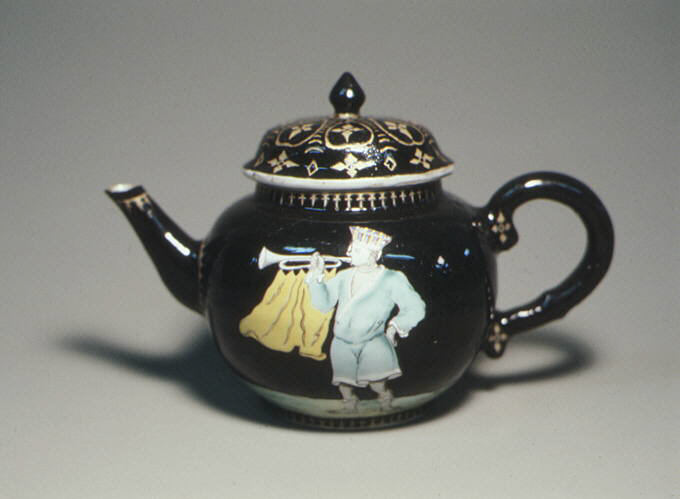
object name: teapot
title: Teapot (part of a service)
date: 1780-1790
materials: hard paste porcelain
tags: men,trumpets